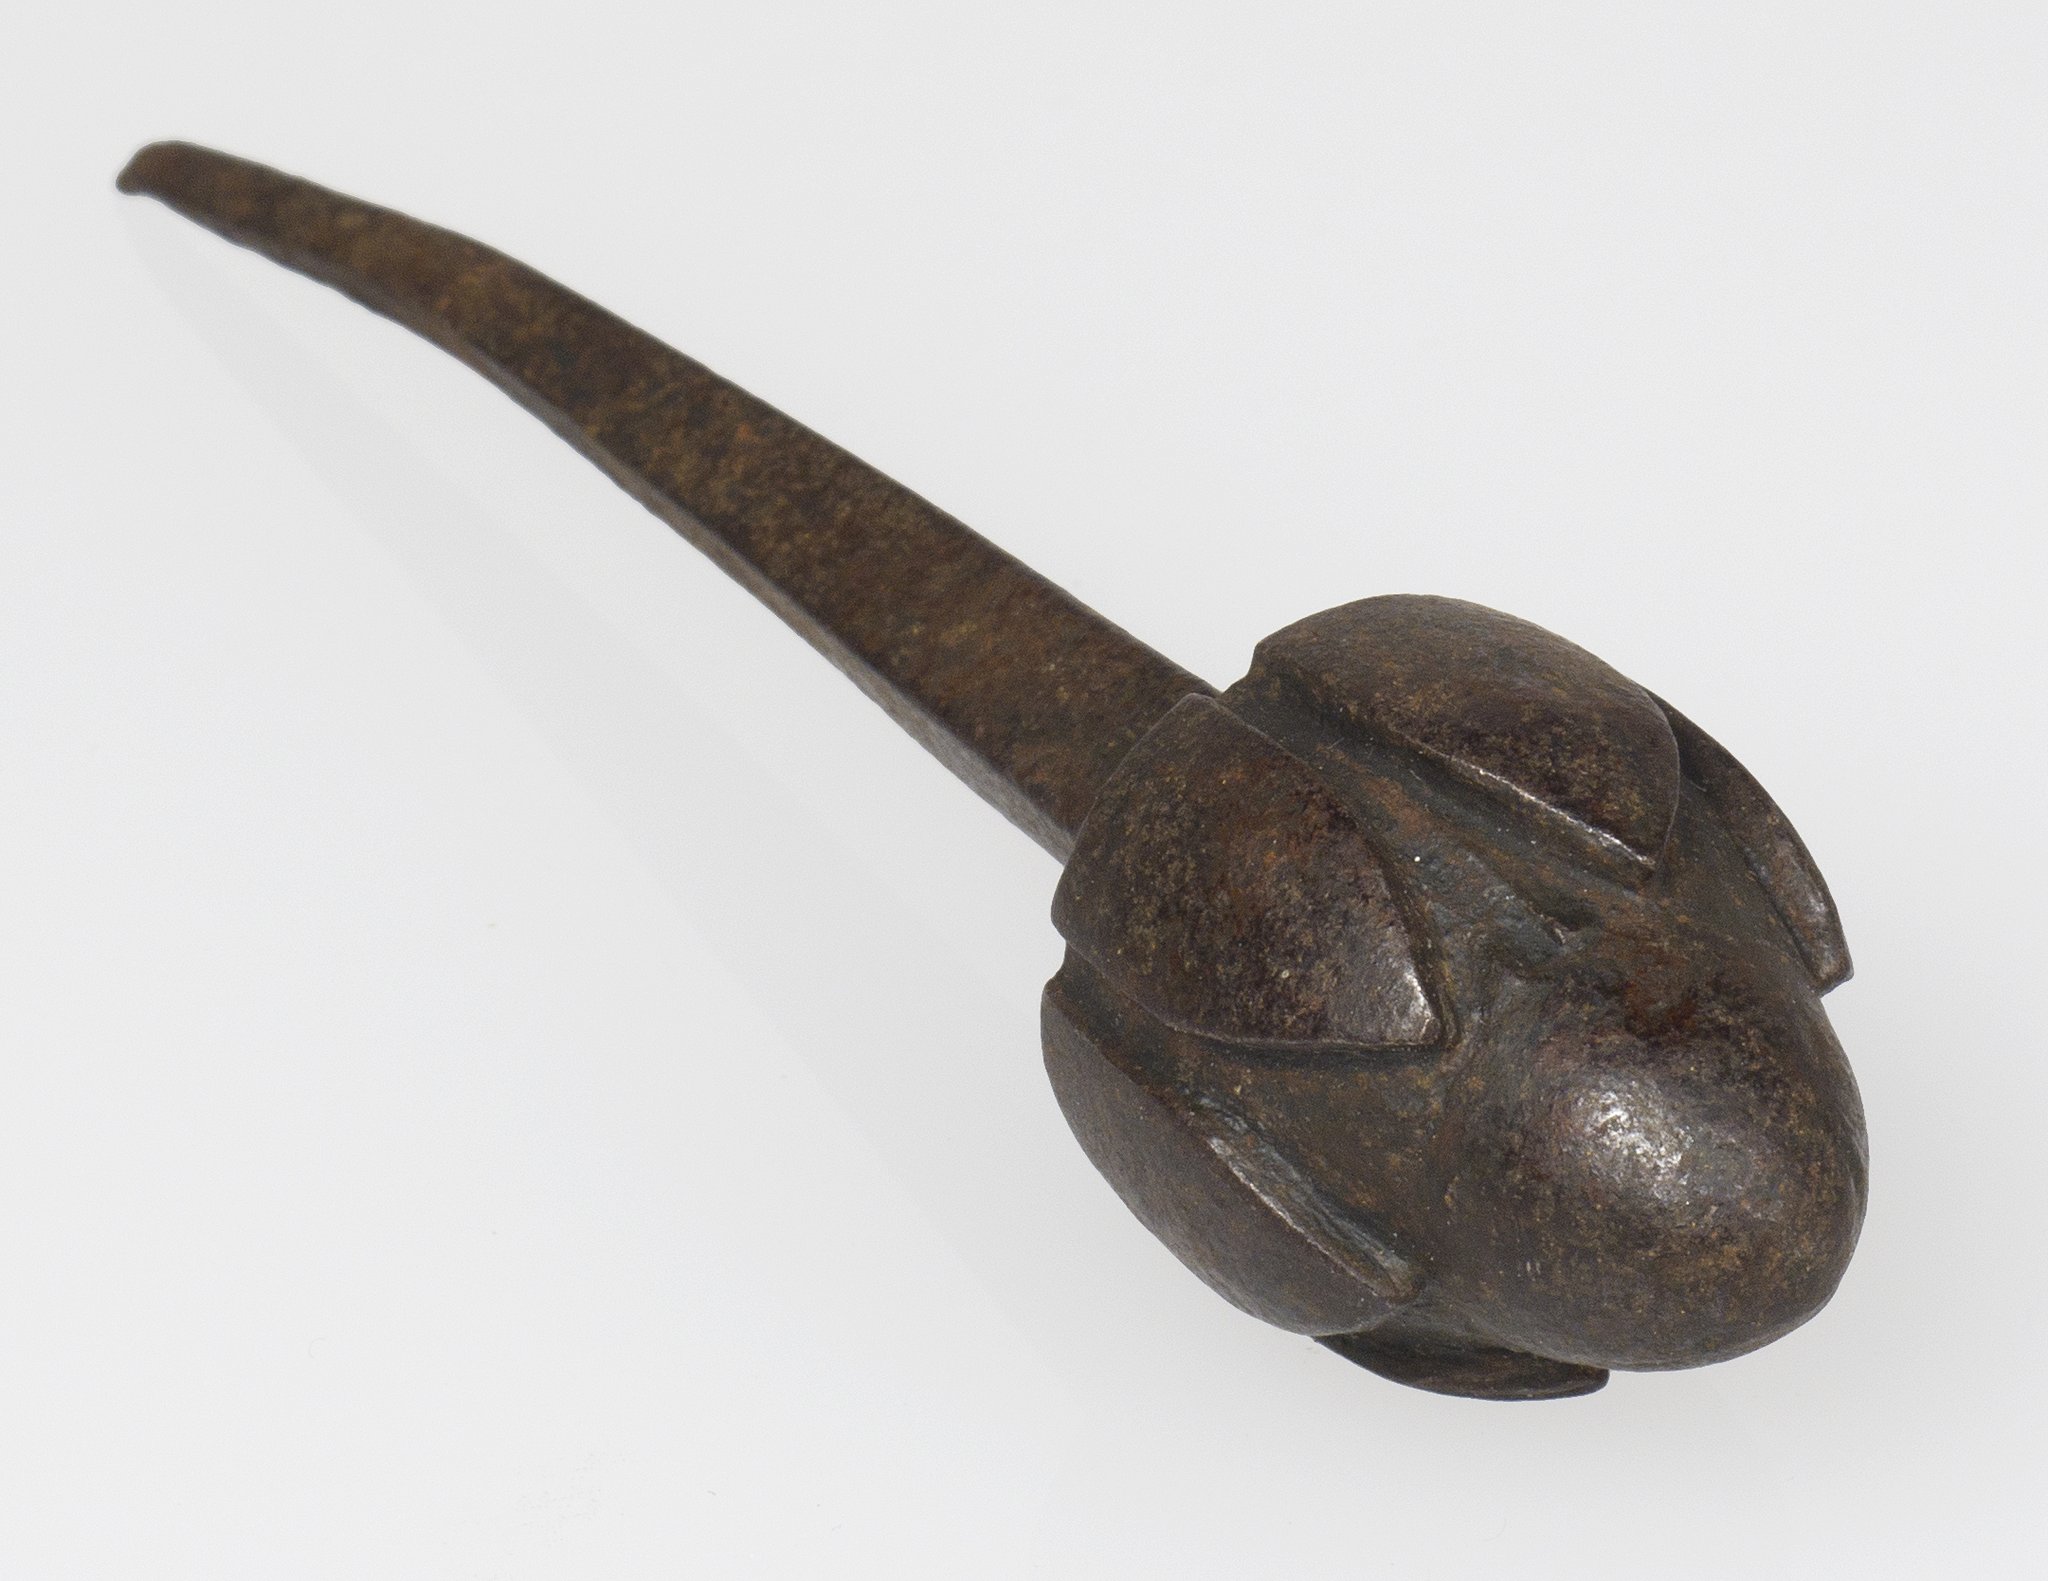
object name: nail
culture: european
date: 1401-1600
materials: iron